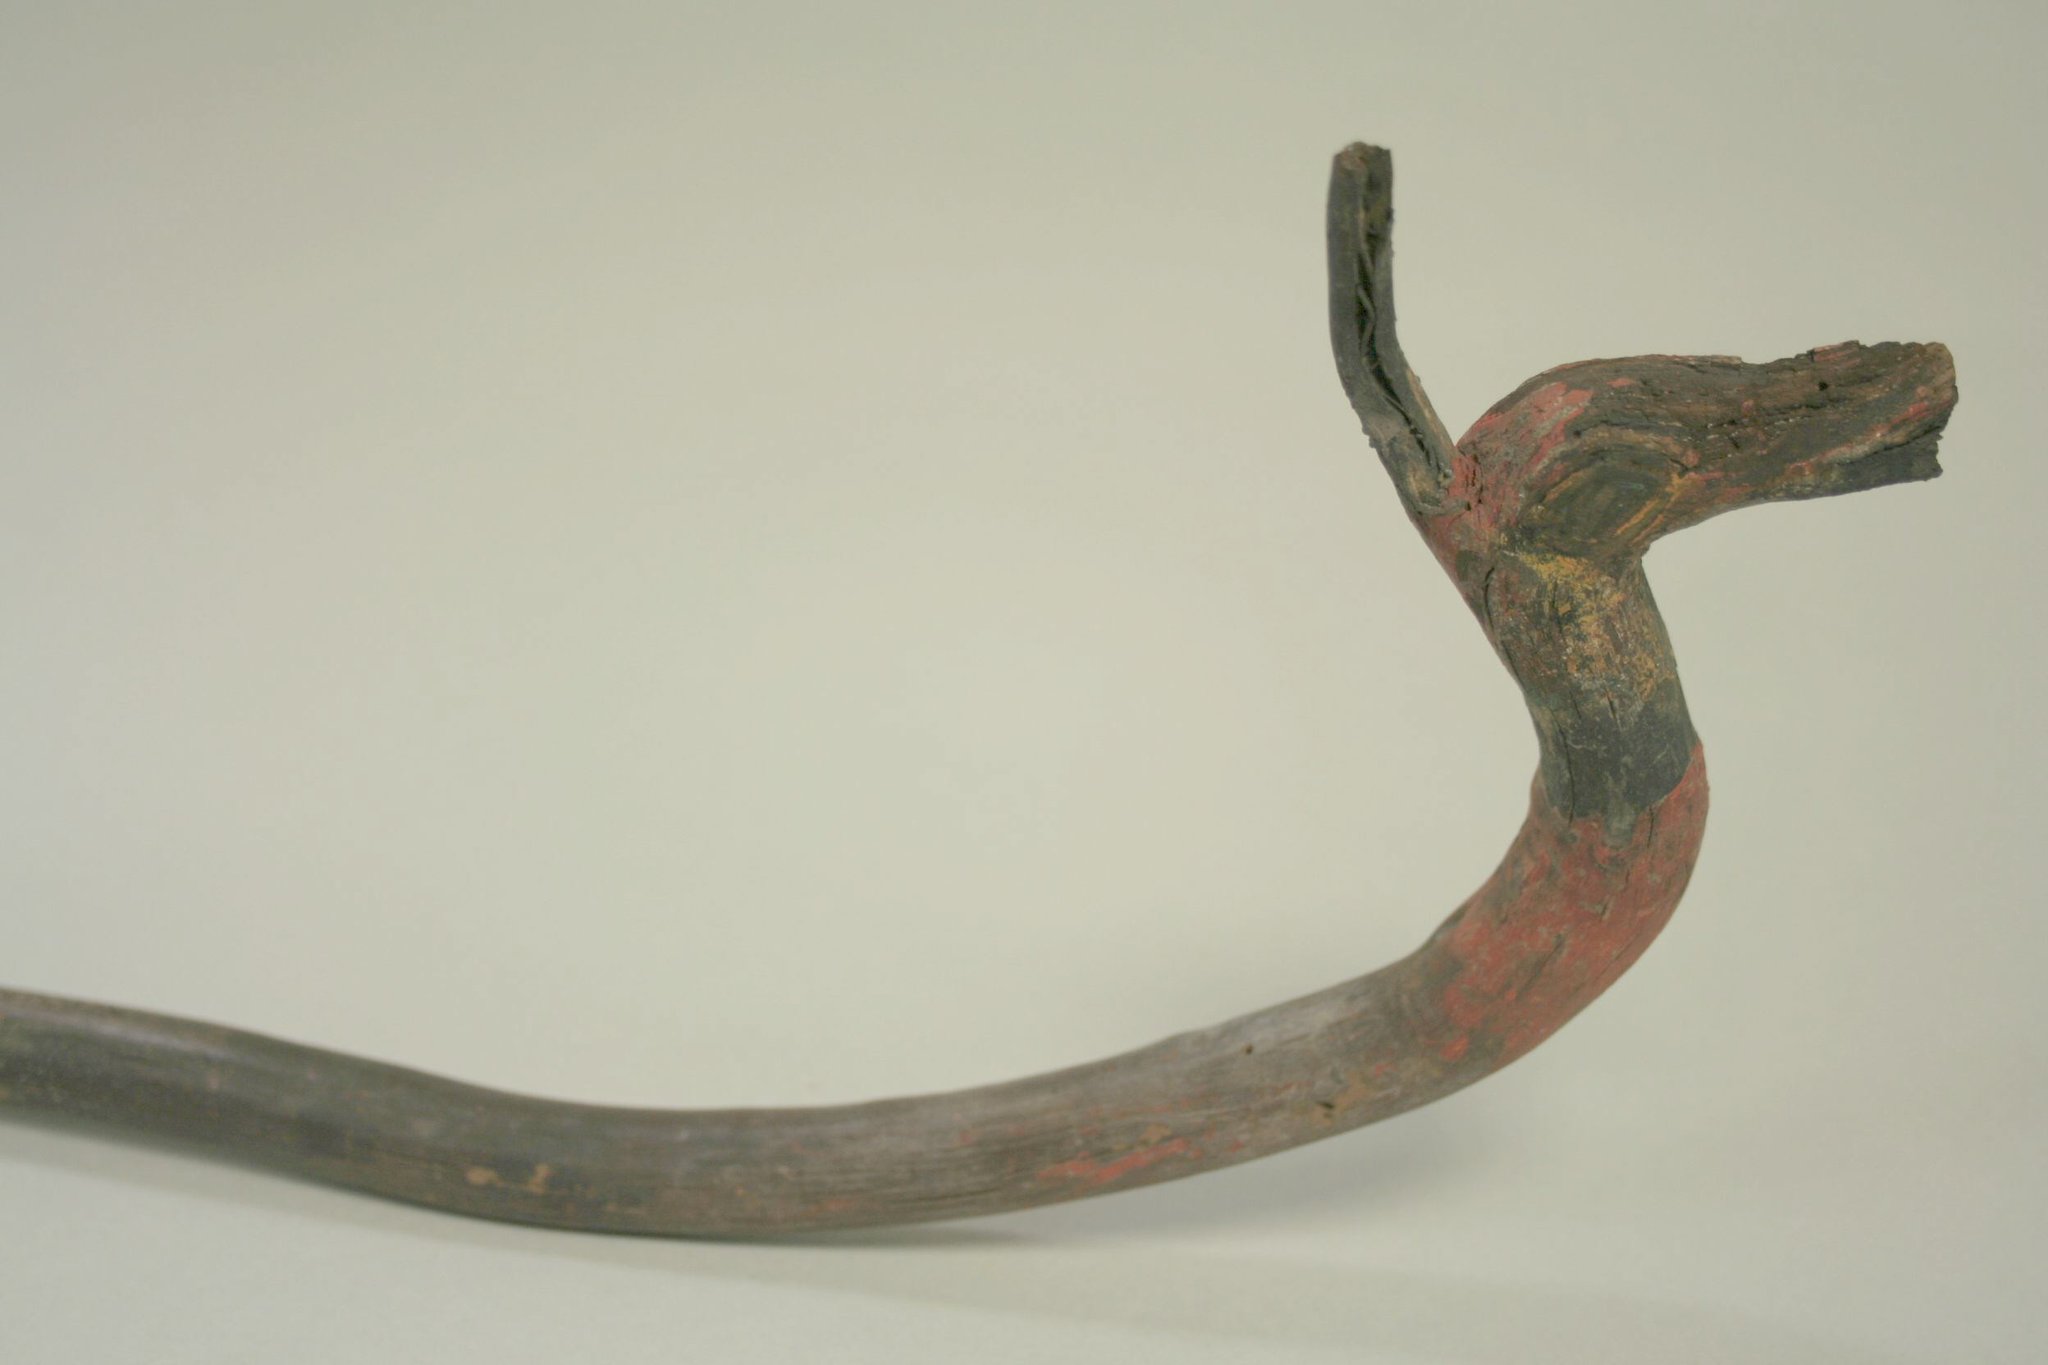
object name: staff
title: Deer Stick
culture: inca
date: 1401-1600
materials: paint, wood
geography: peru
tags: deer